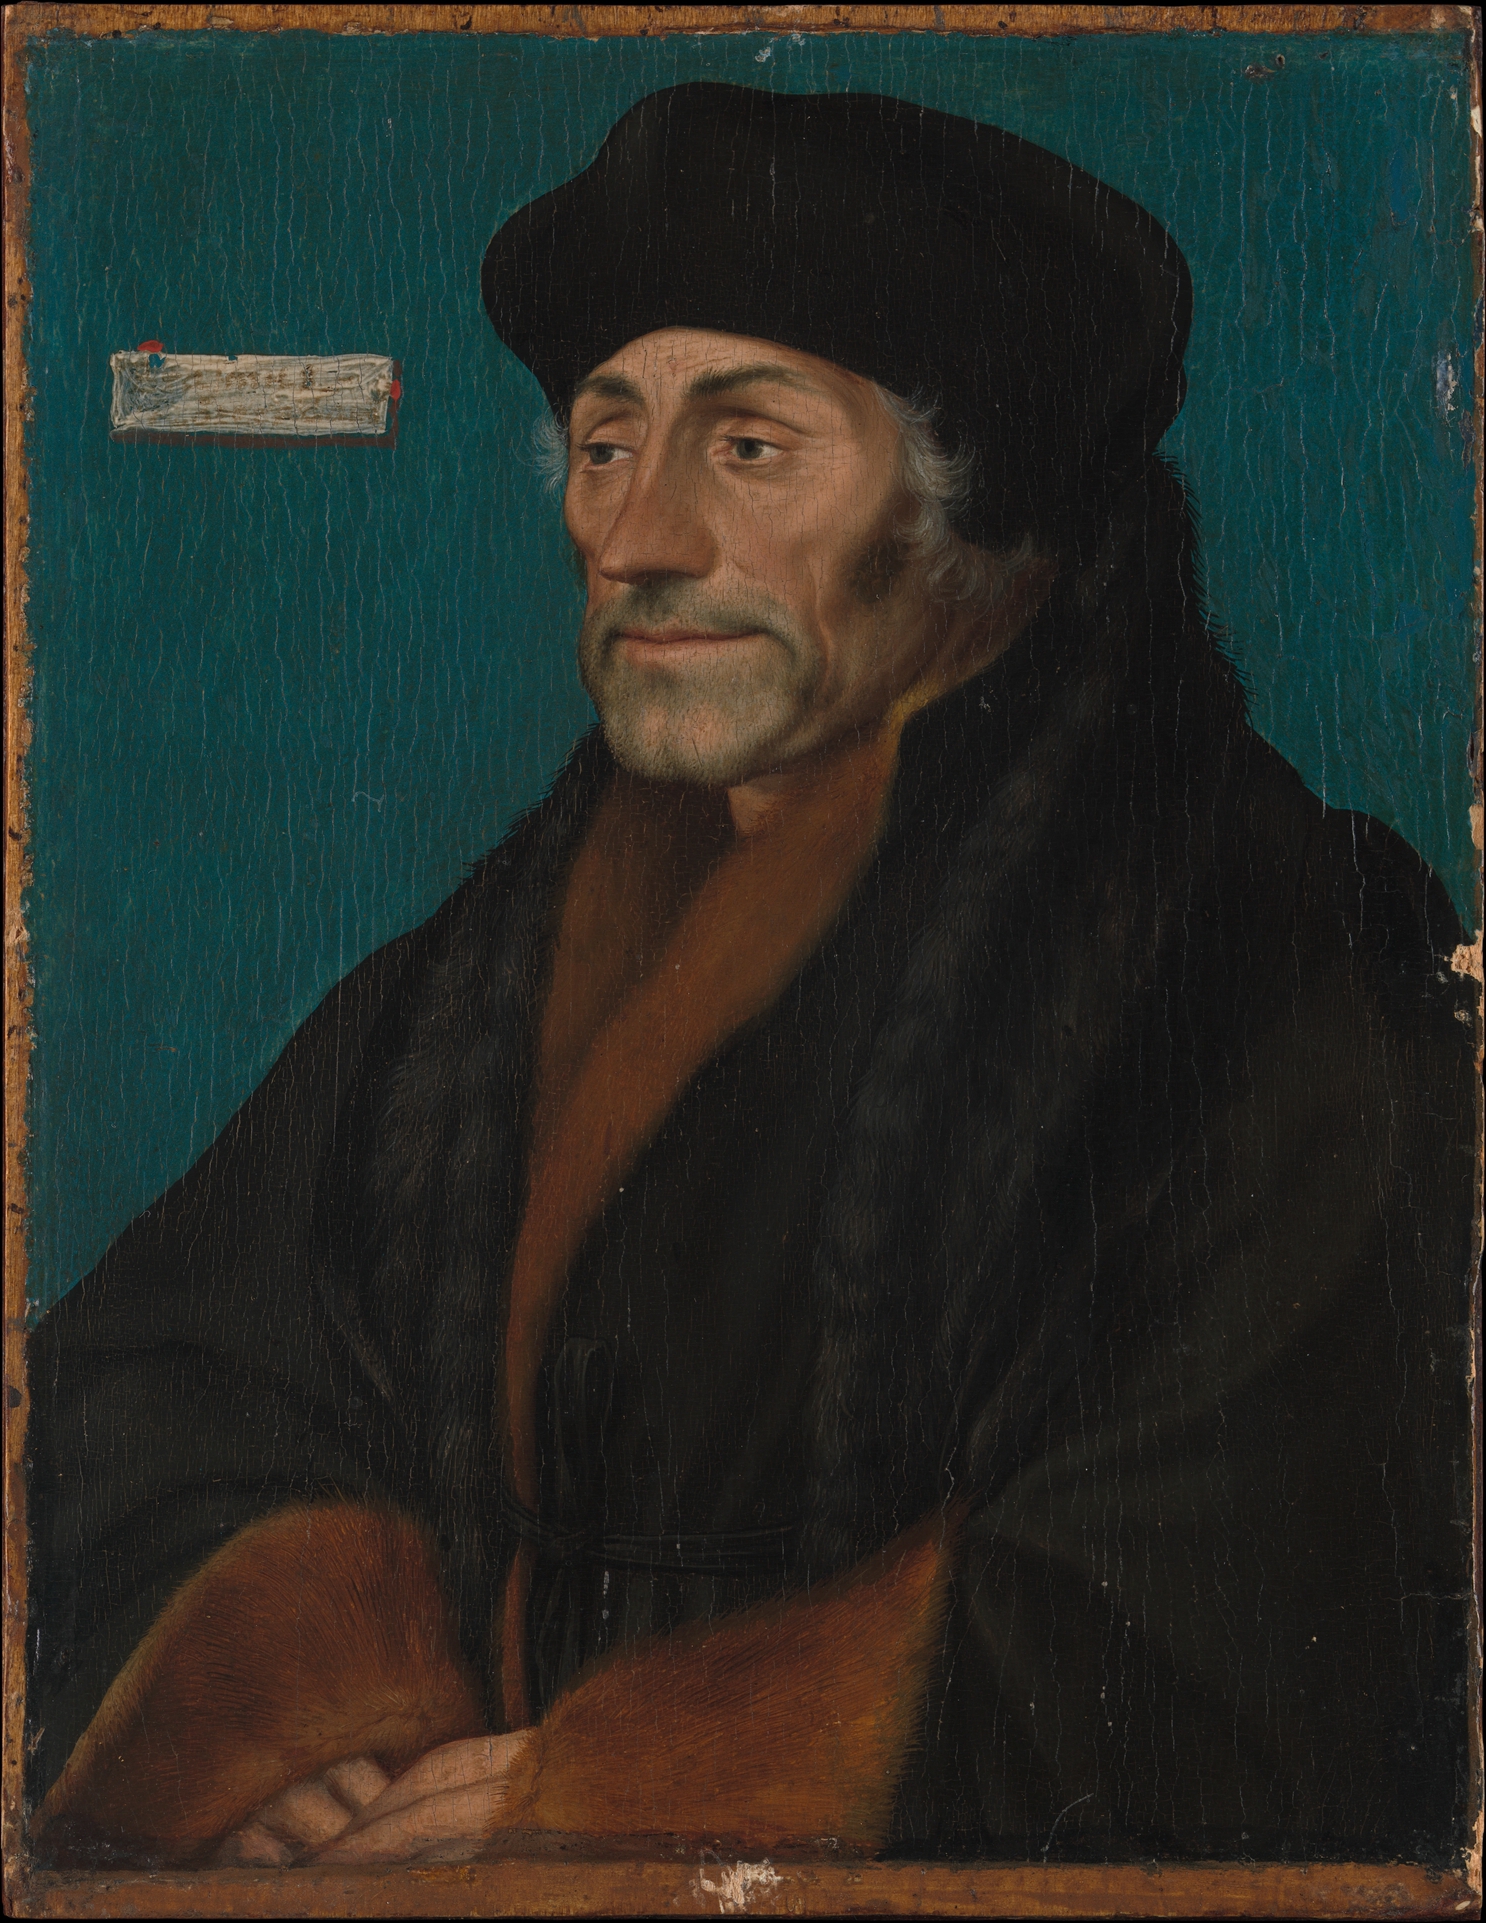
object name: painting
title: Erasmus of Rotterdam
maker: hans holbein the younger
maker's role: artist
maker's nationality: german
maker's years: 1497-1543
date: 1532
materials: wood, oil, panel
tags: men,portraits